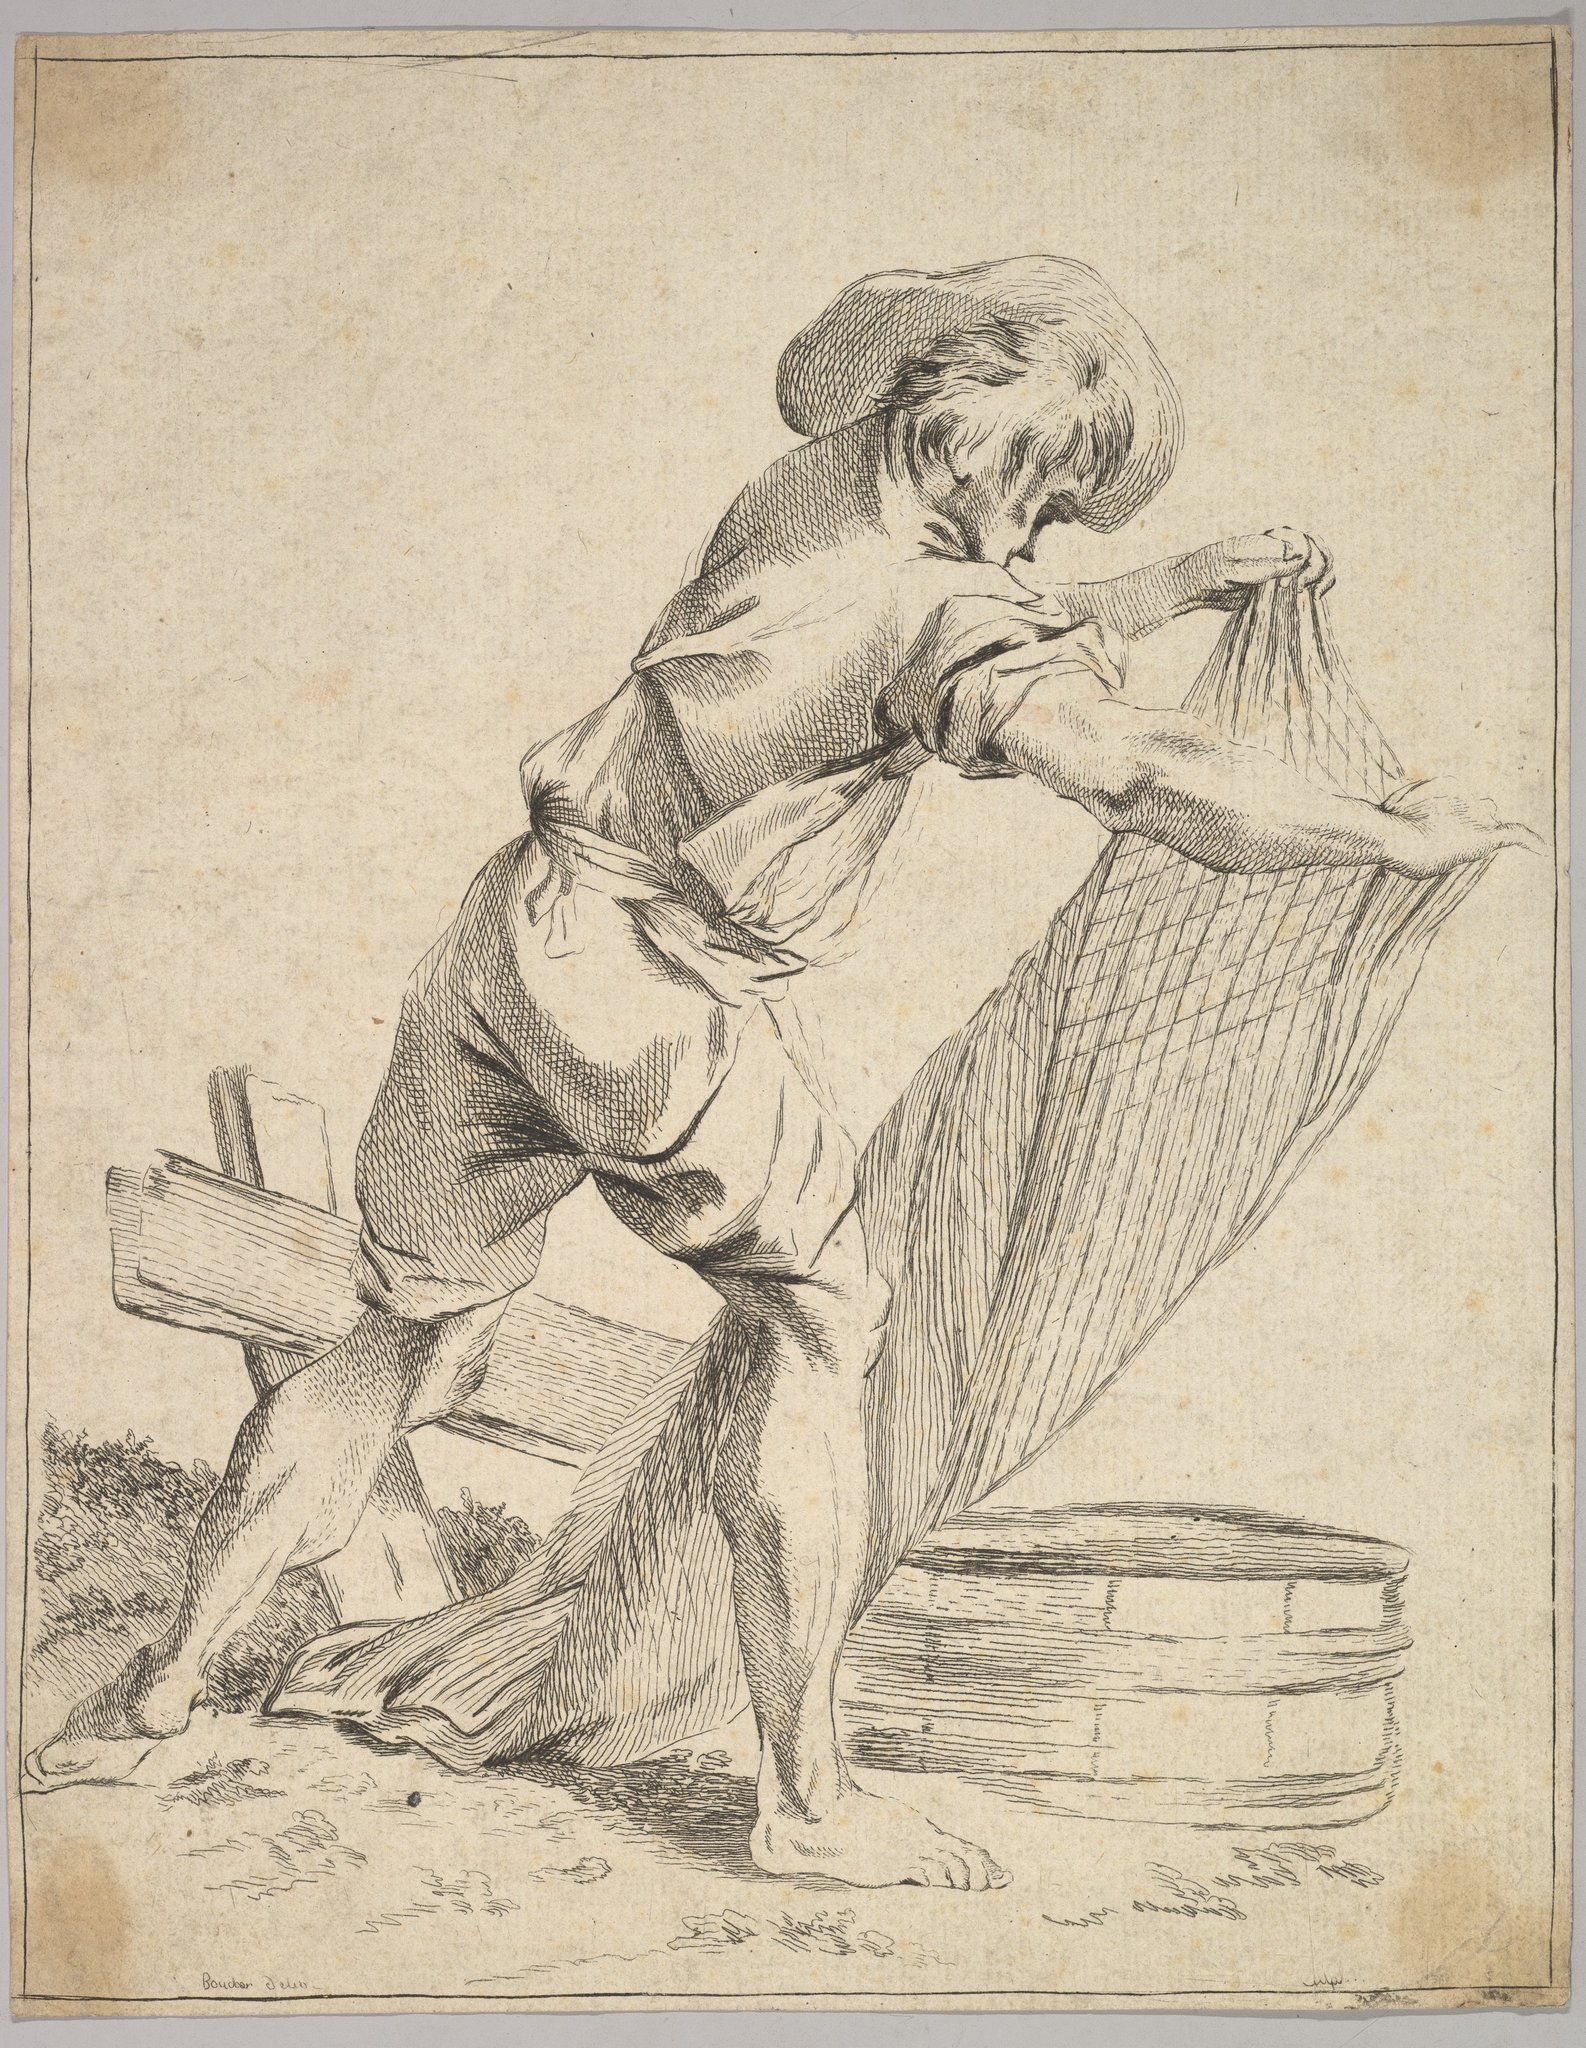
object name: print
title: Peasant Holding Fish Net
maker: françois boucher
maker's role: artist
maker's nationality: french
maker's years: 1703-1770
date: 1701-1800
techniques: etching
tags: men,working